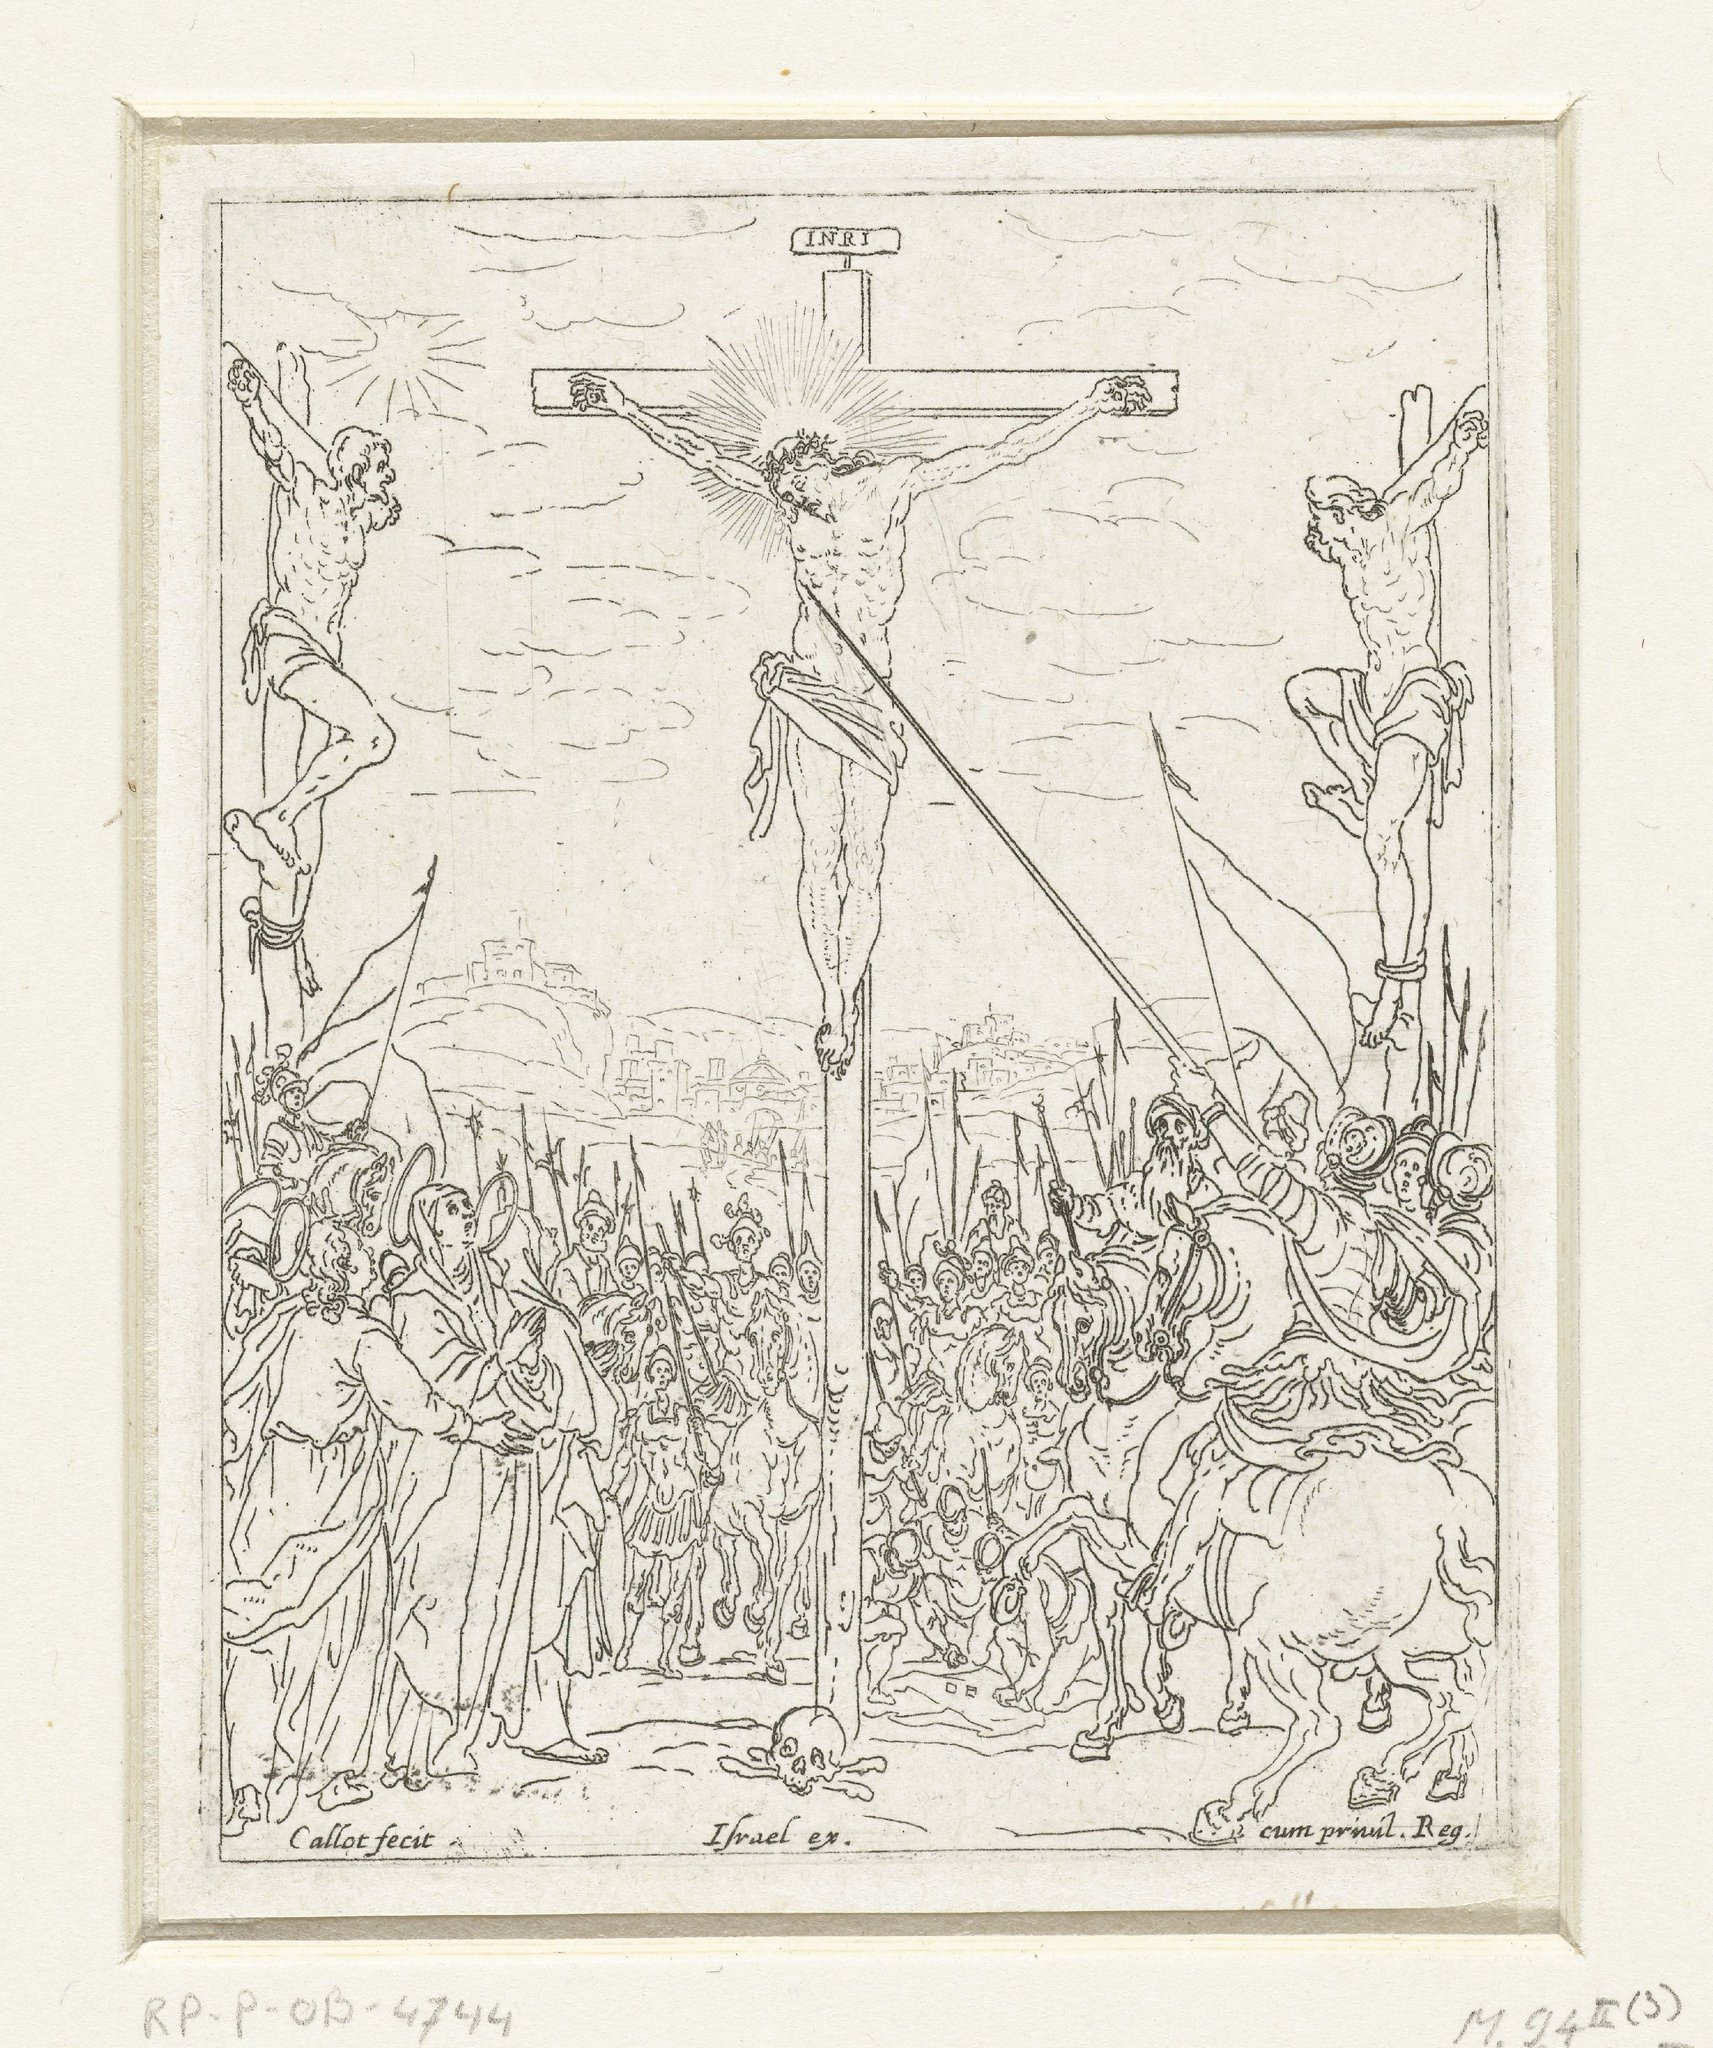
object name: print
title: Kruisiging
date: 1621-1635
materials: paper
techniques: etching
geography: paris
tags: longinus pierces christ's side with a lance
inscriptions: collector's mark: Lugt 240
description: Christus aan het kruis te midden van de twee gekruisigde misdadigers. Een soldaat steekt juist de punt van zijn lans in Christus' zijde. Onvoltooide prent, de voorstelling is slechts in contouren weergegeven.